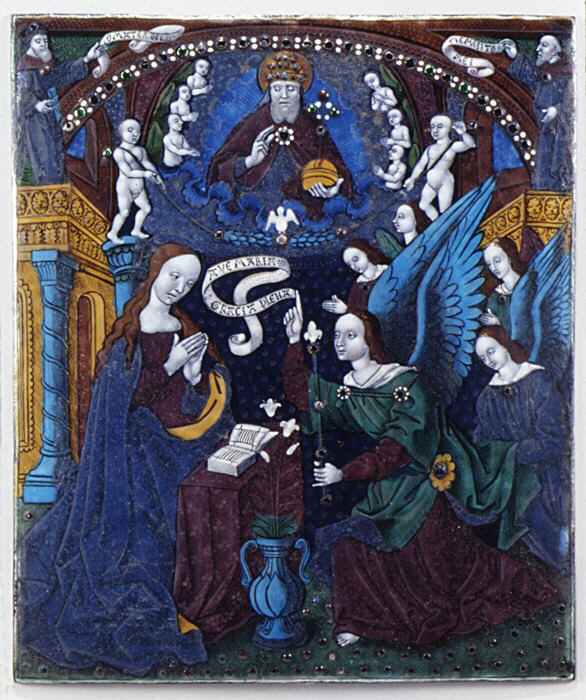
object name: panel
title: The Annunciation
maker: master of the triptych of louis xii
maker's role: enameler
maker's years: 1480-1525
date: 1501-1533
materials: copper, enamel, gilt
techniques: painting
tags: queens,angels,annunciation